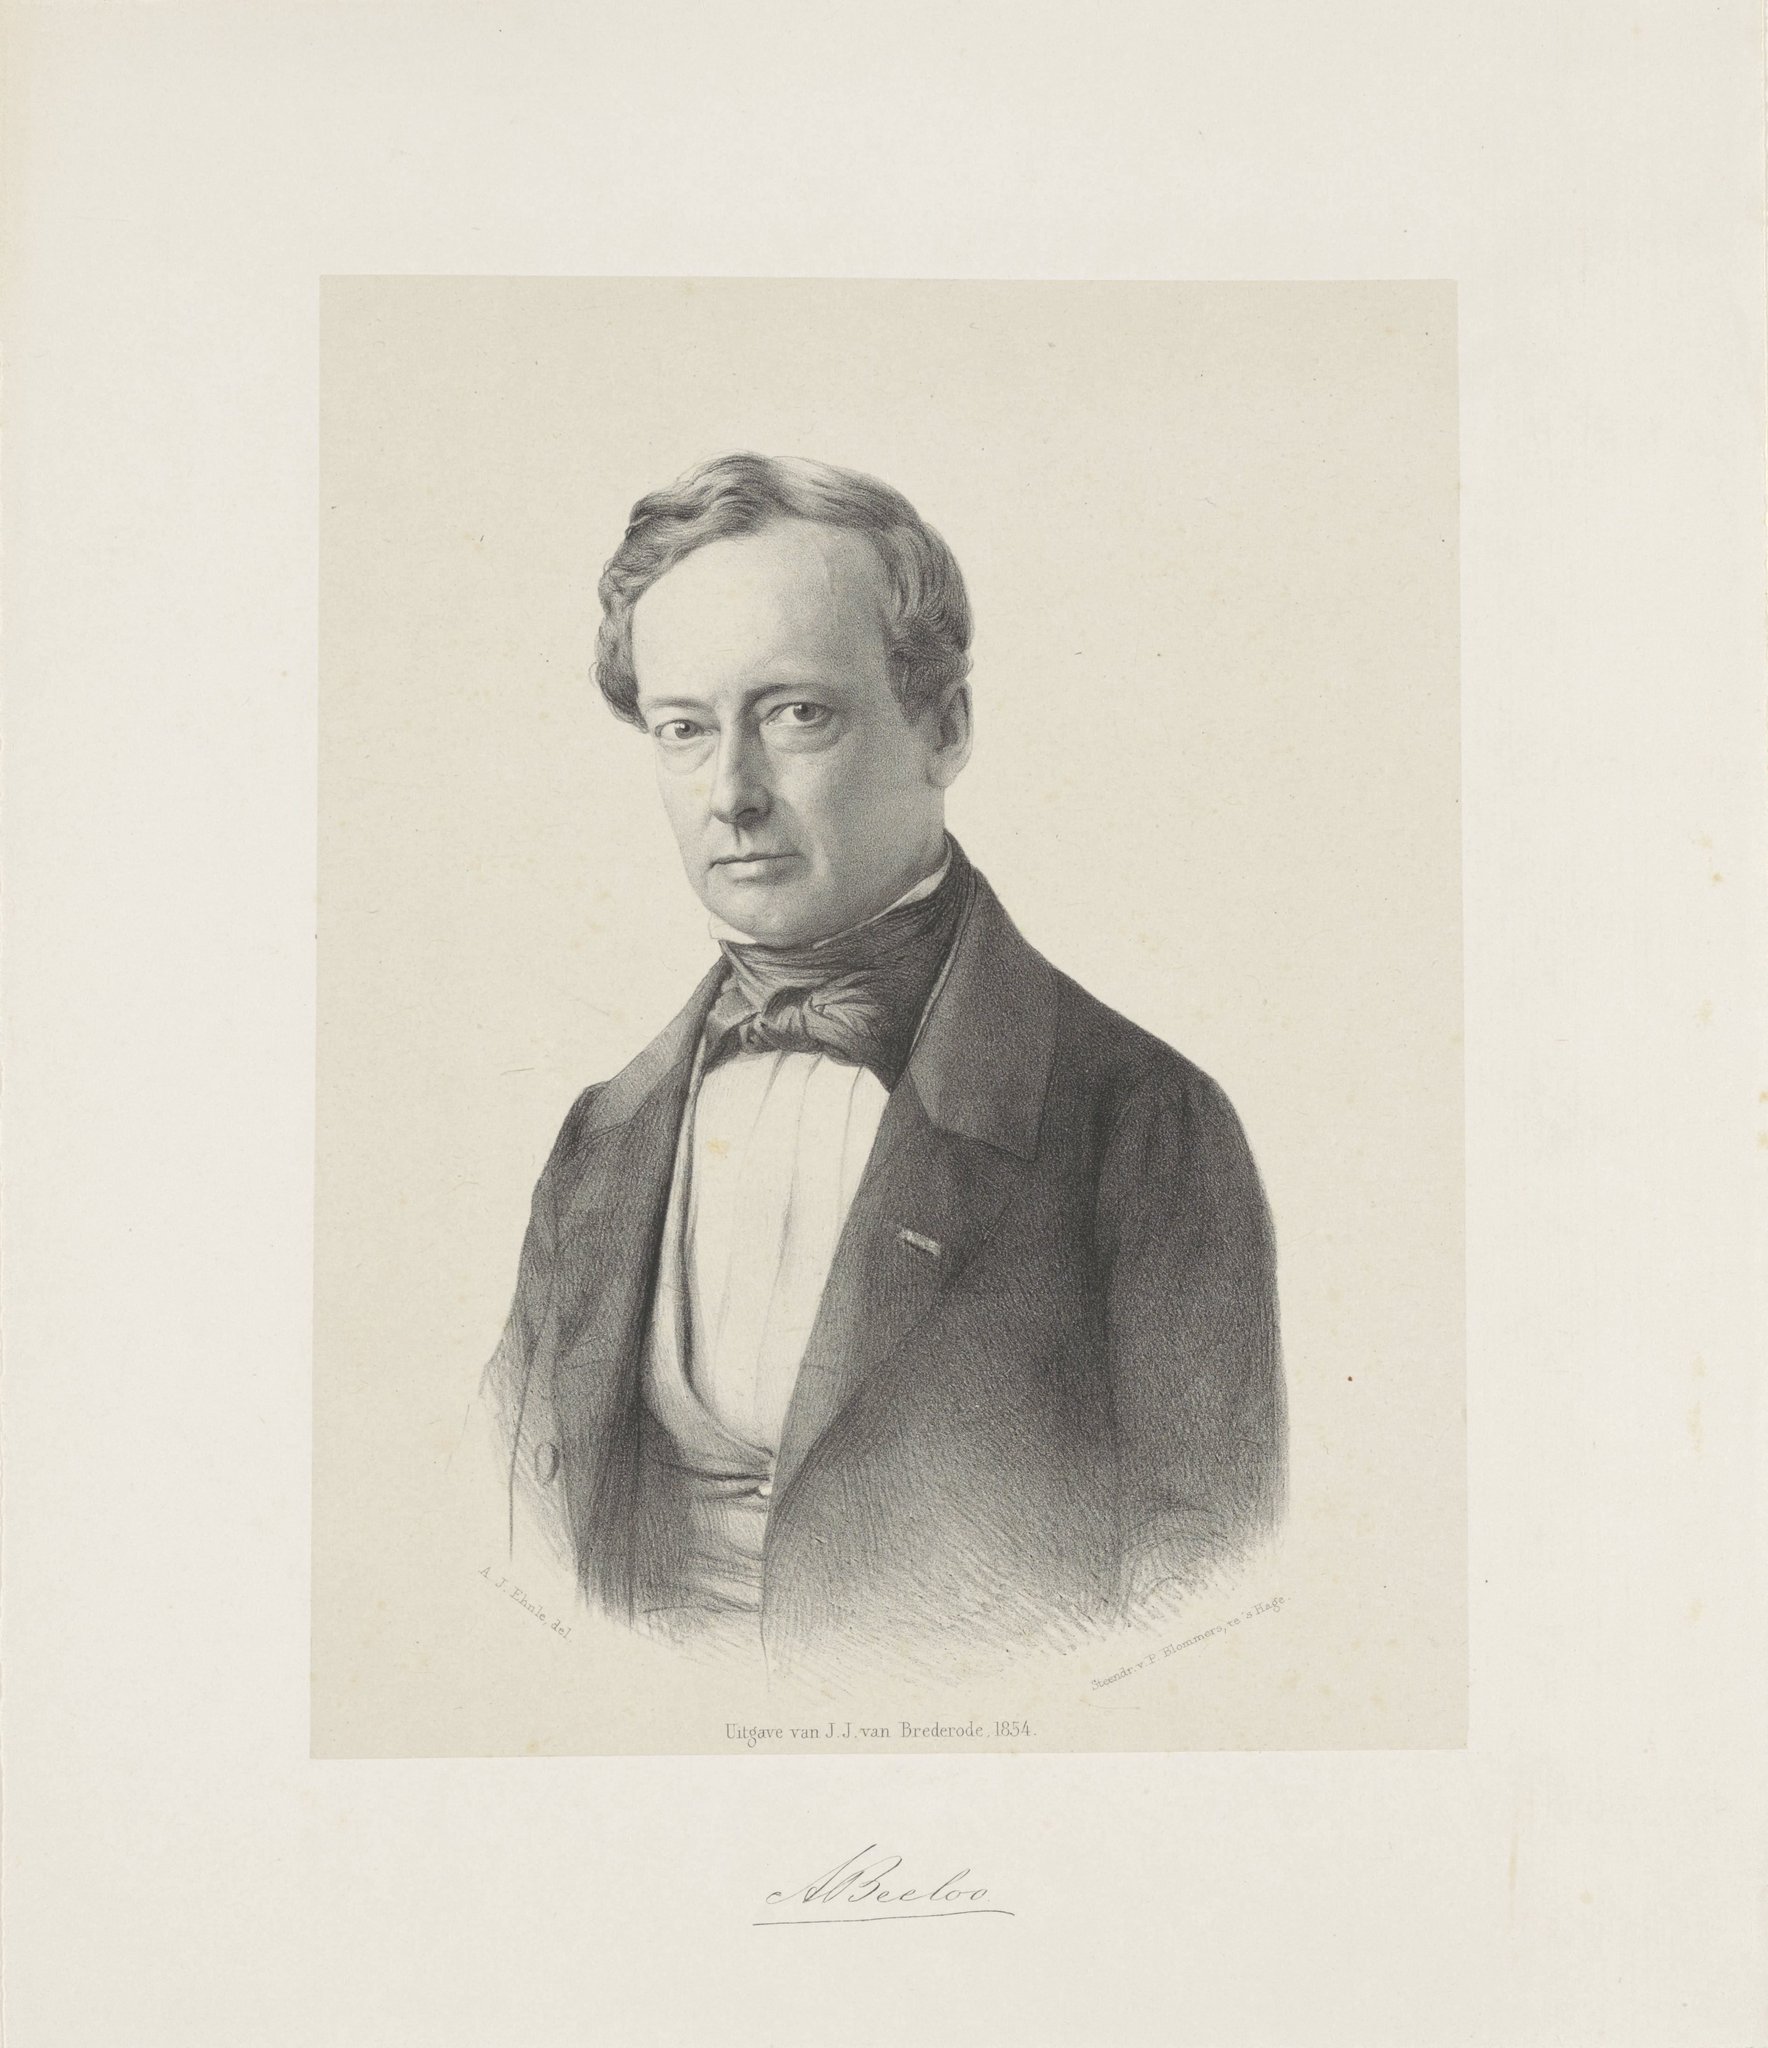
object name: print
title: Portret van Adriaan Beeloo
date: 1847-1883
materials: paper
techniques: lithograph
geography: haarlem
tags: the hague, adriaan beeloo, historical persons (+ (full) bust portrait)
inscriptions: collector's mark: Lugt 2228, collector's mark: Lugt 2233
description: De geportretteerde draagt een gestrikte das en openhangende jas met ridderorde. Onder het portret zijn signatuur.